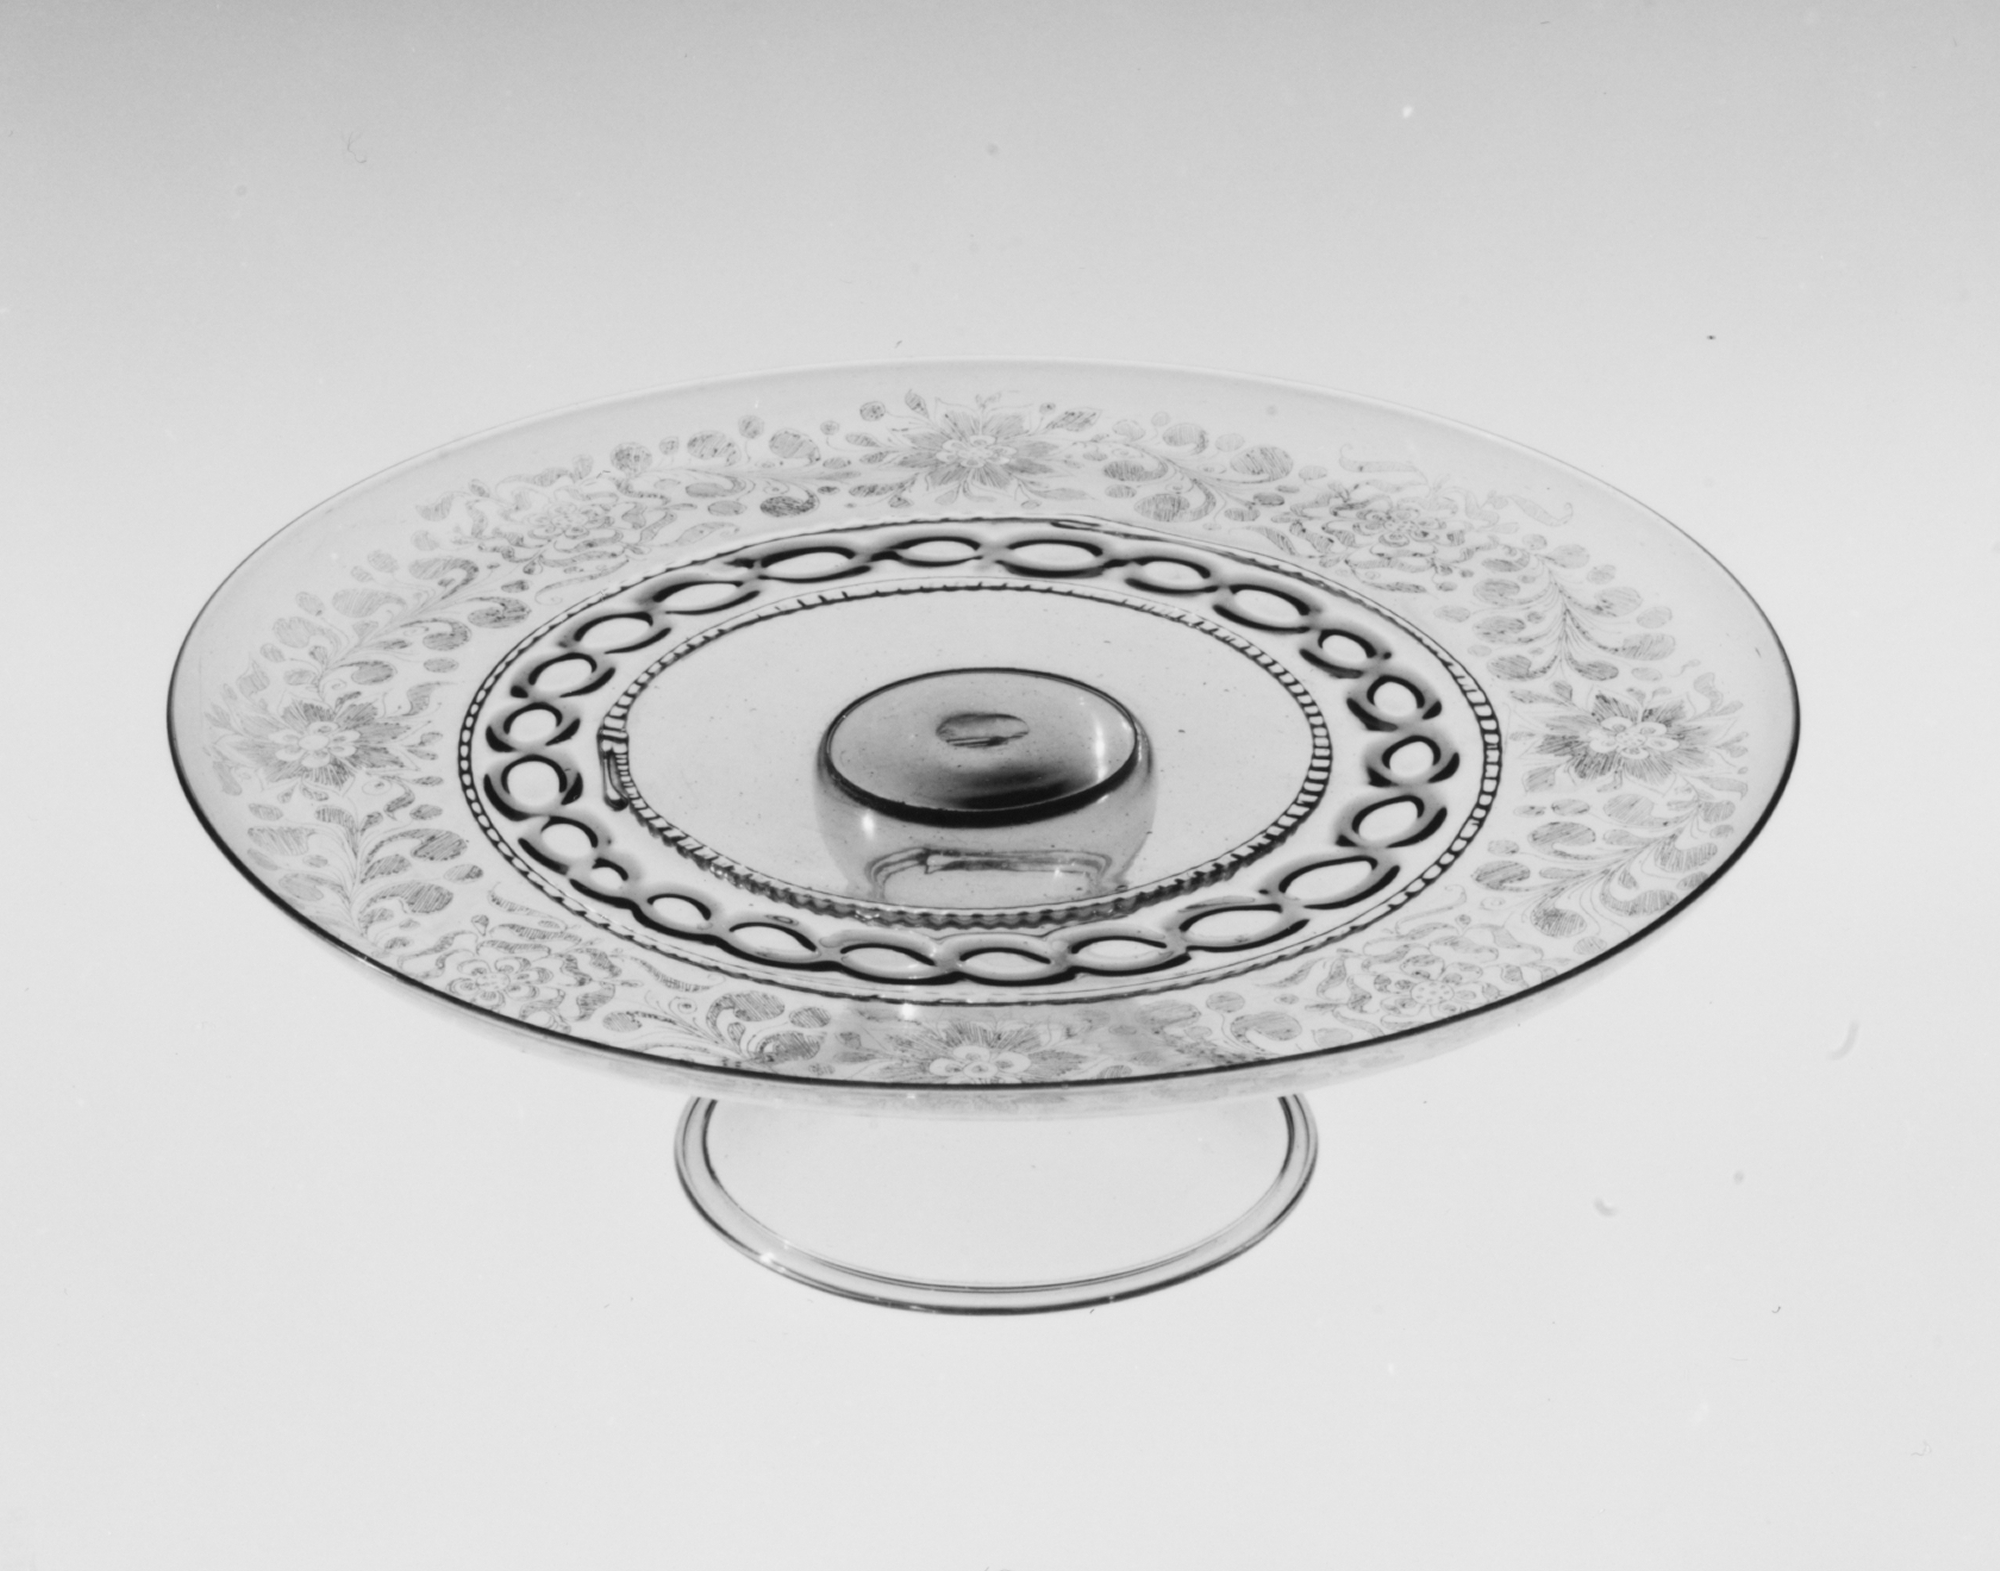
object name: tazza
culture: italian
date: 1601-1700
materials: diamond, glass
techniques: glassblowing, engraving